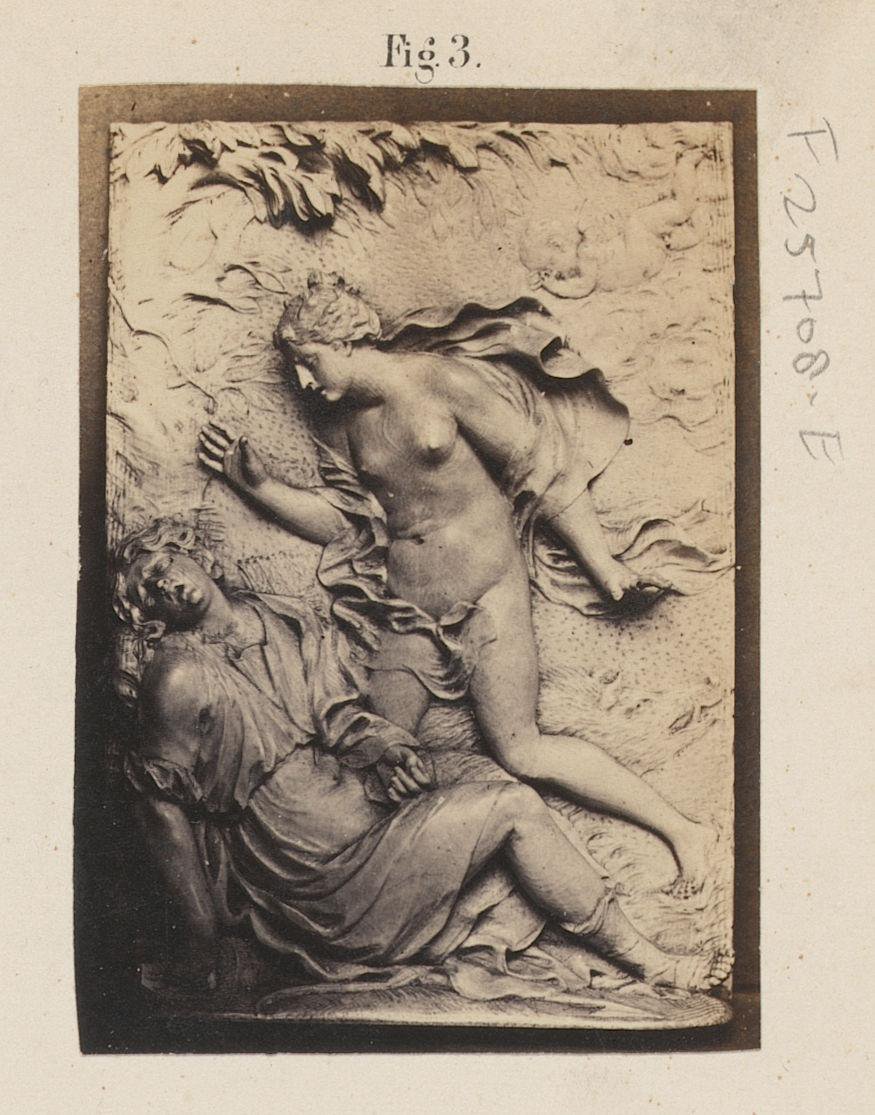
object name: photograph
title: Ivoren snijwerk door Francis van Bossuit op de Tentoonstelling van oudheden in Delft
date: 1855-1863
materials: cardboard, paper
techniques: albumen print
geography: delft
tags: carving ~ applied arts, delft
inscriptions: inscription: ‘PLAAT VI.’, inscription: ‘Fig. 3.’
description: Deze foto maakt deel uit van een omslag met 35 foto's op 16 bladen.